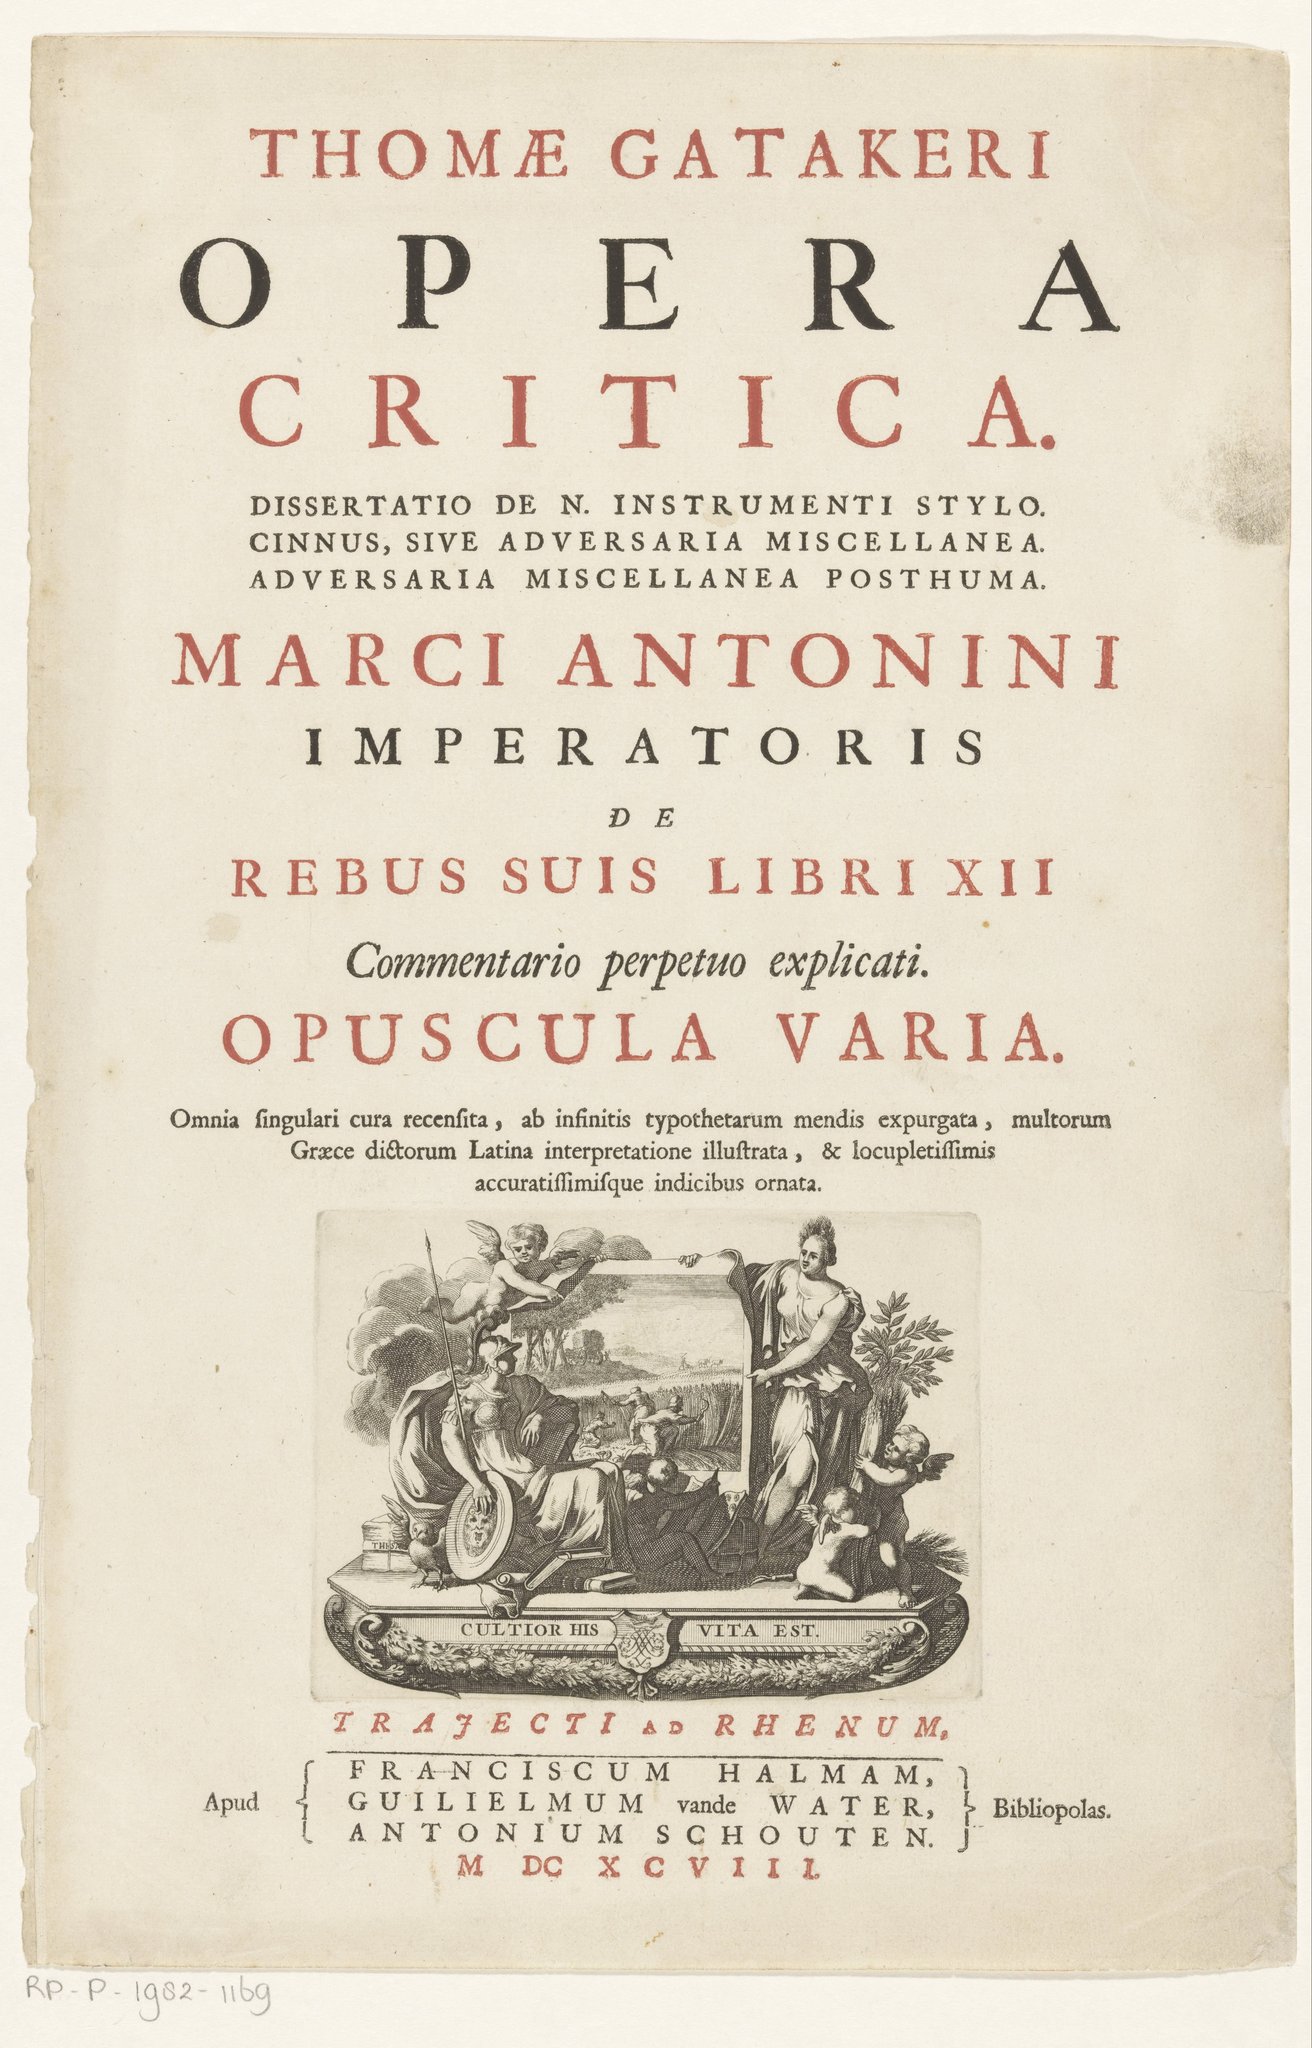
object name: print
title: Minerva en Ceres met afbeelding van mensen werkend op het land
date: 1698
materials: paper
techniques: engraving, letterpress printing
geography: utrecht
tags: (story of) ceres (demeter), (story of) minerva (pallas, athena), device (trade-mark of printer or publisher), agriculture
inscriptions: collector's mark: Lugt 2228, collector's mark: Lugt 2760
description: Drukkersmerk: Ceres toont een afbeelding van mensen werkend op het land aan de zittende Minerva met lans, schild en uil. Links en rechts putti.